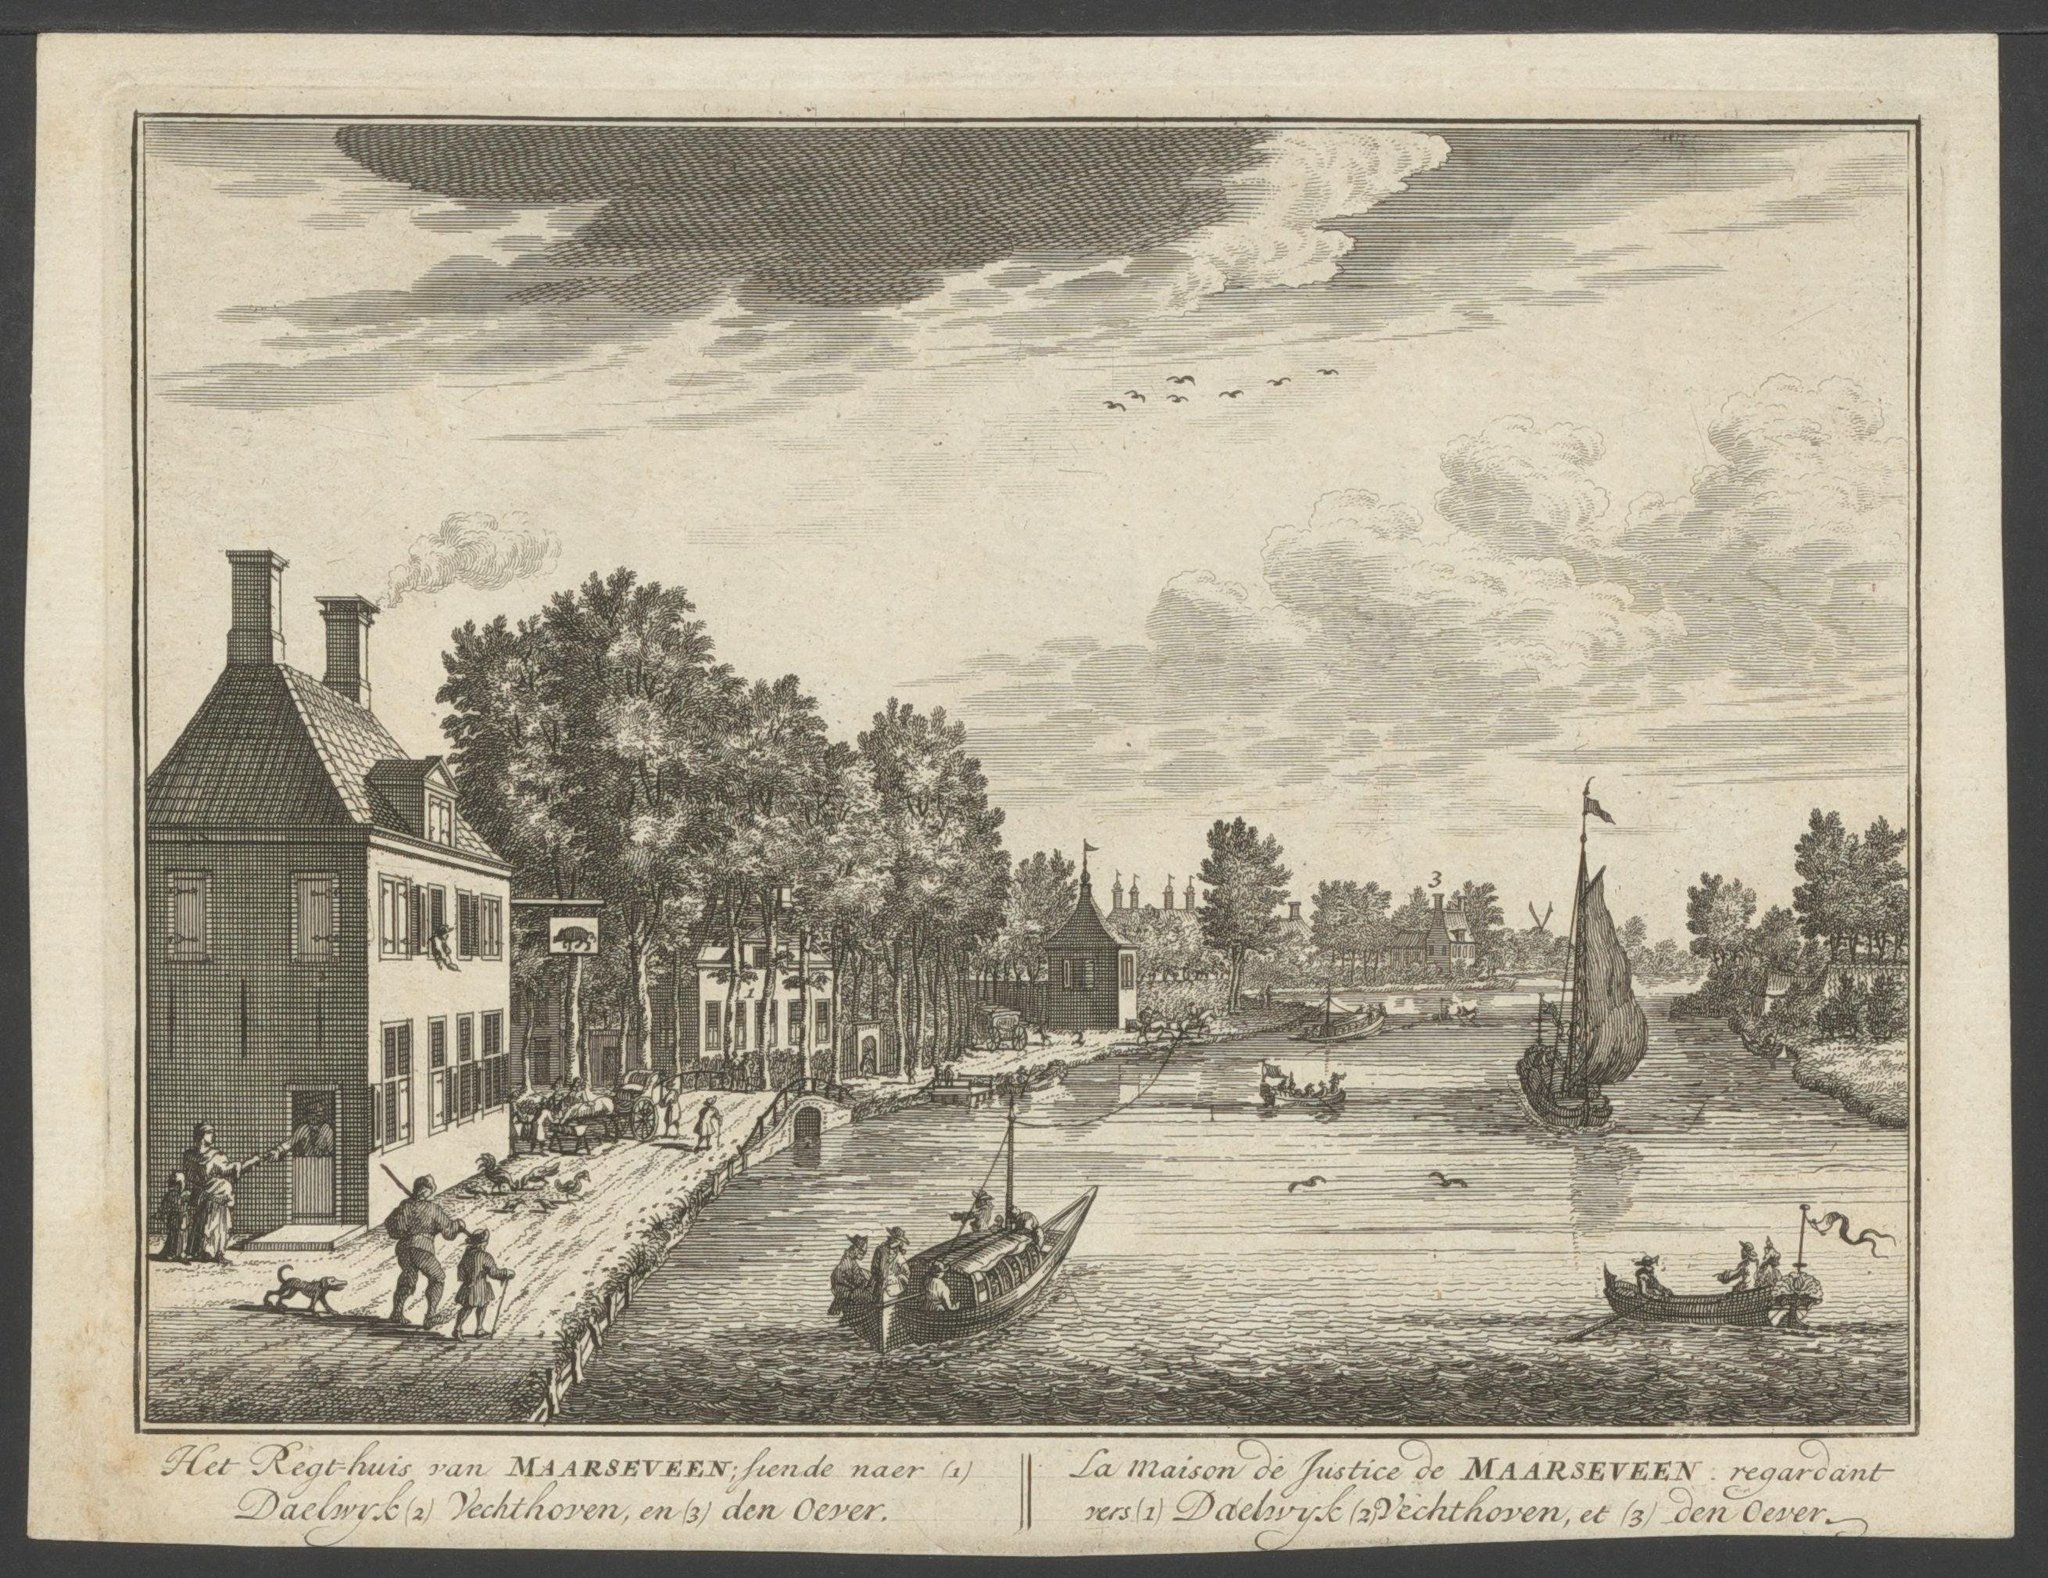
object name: print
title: Gezicht op Oud-Maarseveen aan de Vecht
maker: daniël stopendaal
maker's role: print maker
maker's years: 1672-1726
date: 1719-1790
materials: paper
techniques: engraving, etching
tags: river (+ landscape with figures, staffage), village (+ city(-scape) with figures, staffage), vecht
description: Prent voor het eerst gebruikt in: Leth, Andries de. De zegepraalende Vecht, vertoonende verscheidene gesichten van lustplaatsen, heeren huysen en dorpen, beginnende van Uitrecht en met Muyden besluytende (...). Amsterdam: Weduwe Nicolaus Visscher, 1719. Prent mogelijk uit: Brouërius van Nidek, Matthaeus. De Vechtstroom, van Utrecht tot Muiden (...). Amsterdam: H. Gartman, W. Vermandel en J.W. Smit, 1790.